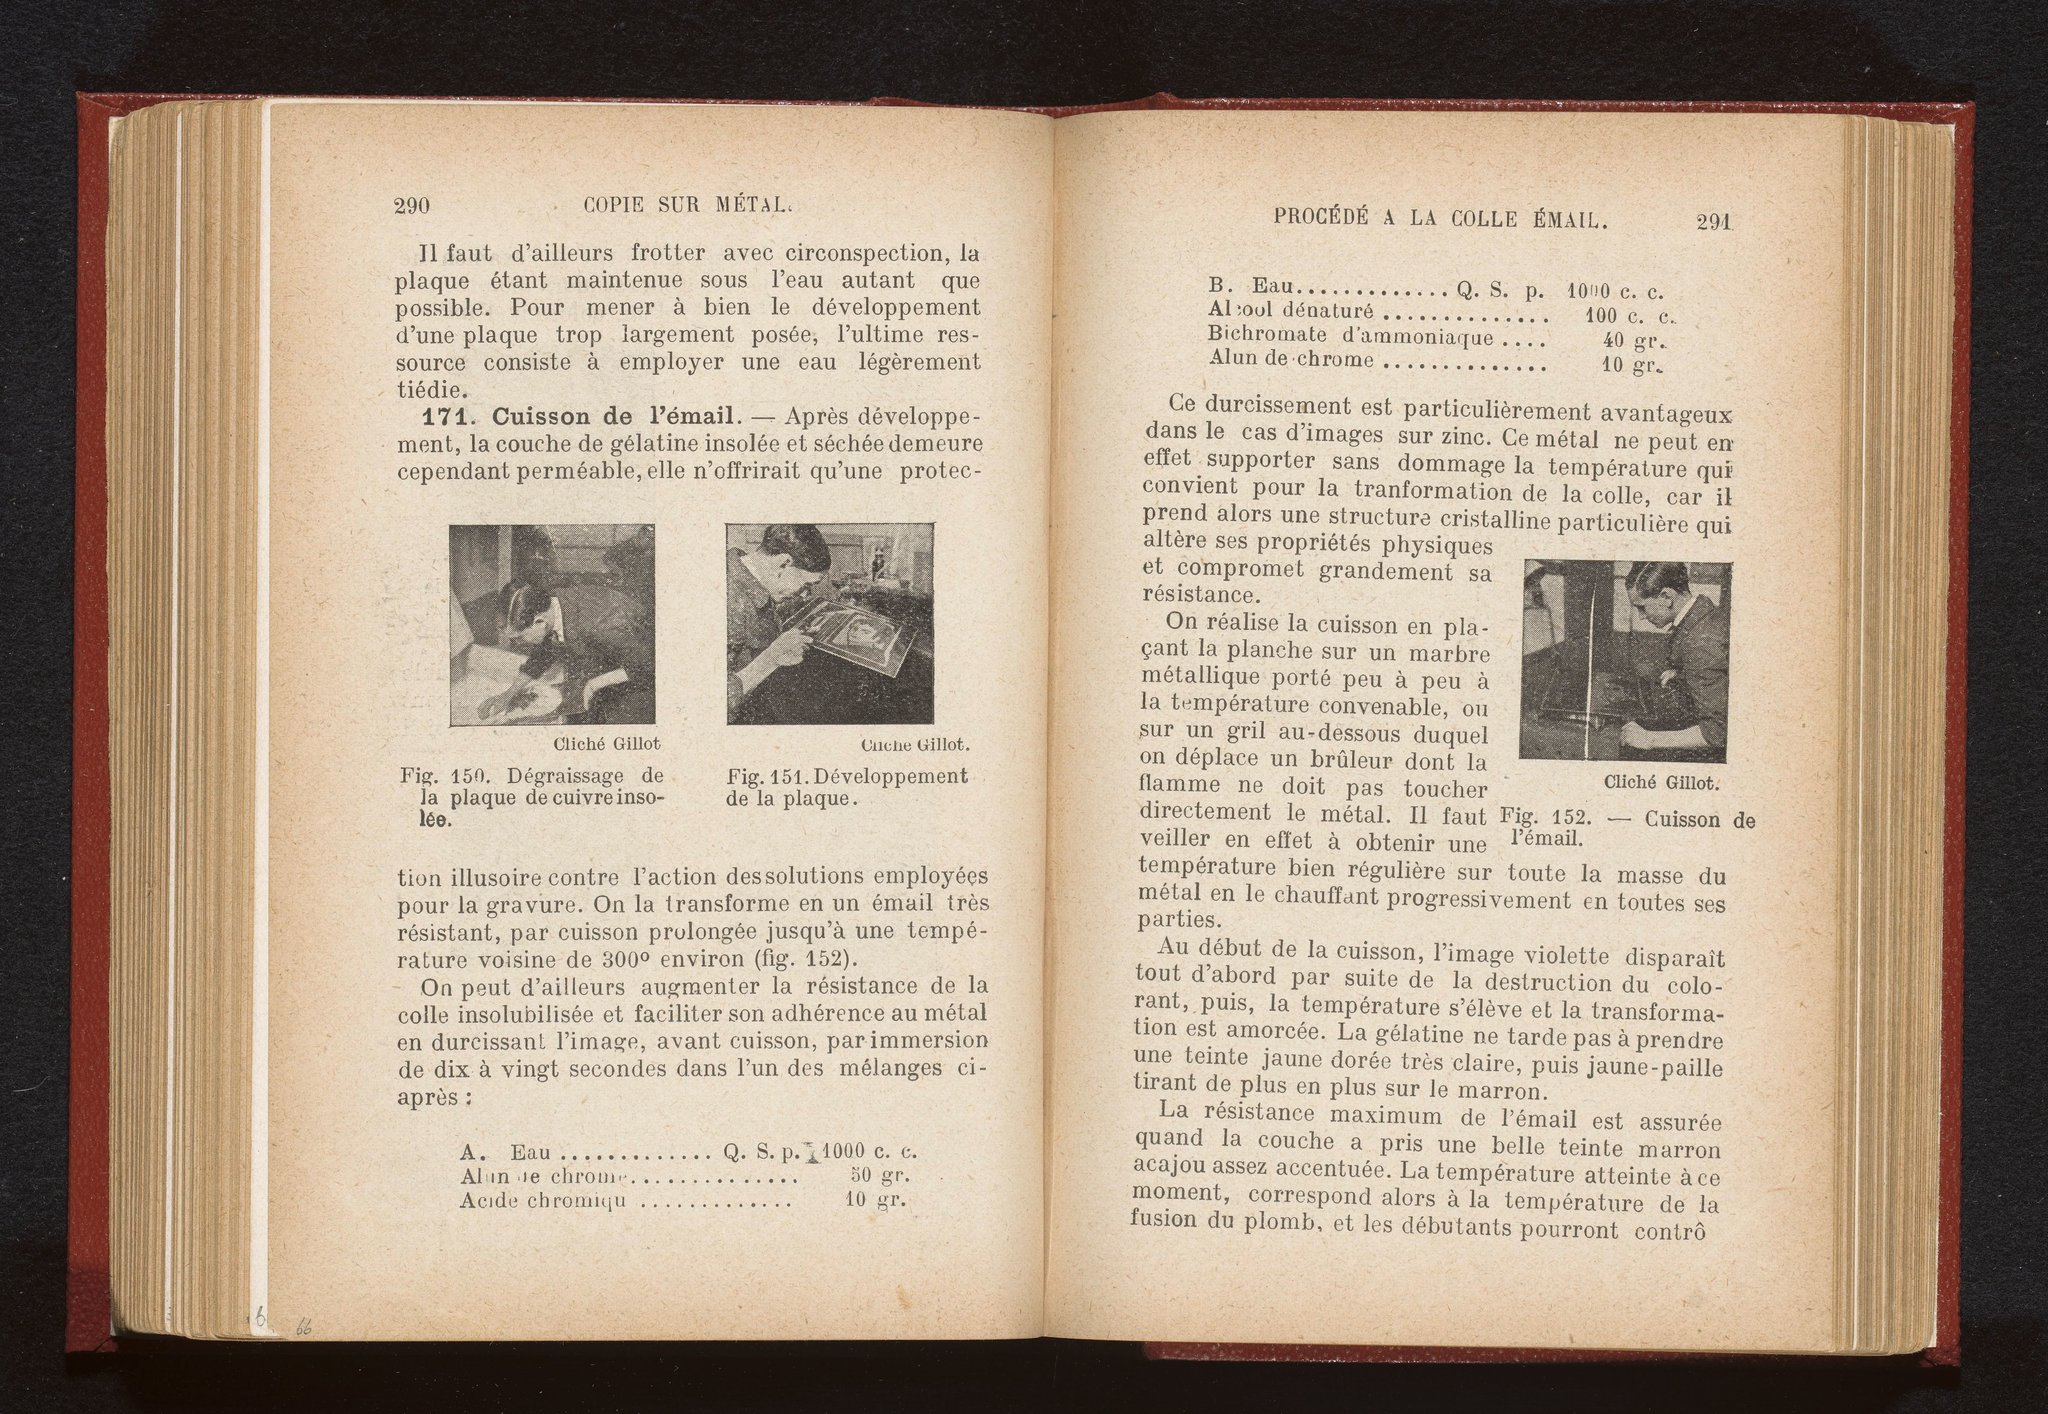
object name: page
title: Cuisson de l'émail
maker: Anonymous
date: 1922-1932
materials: paper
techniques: autotype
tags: enamelling ~ applied arts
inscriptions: number: ‘Fig. 152.’